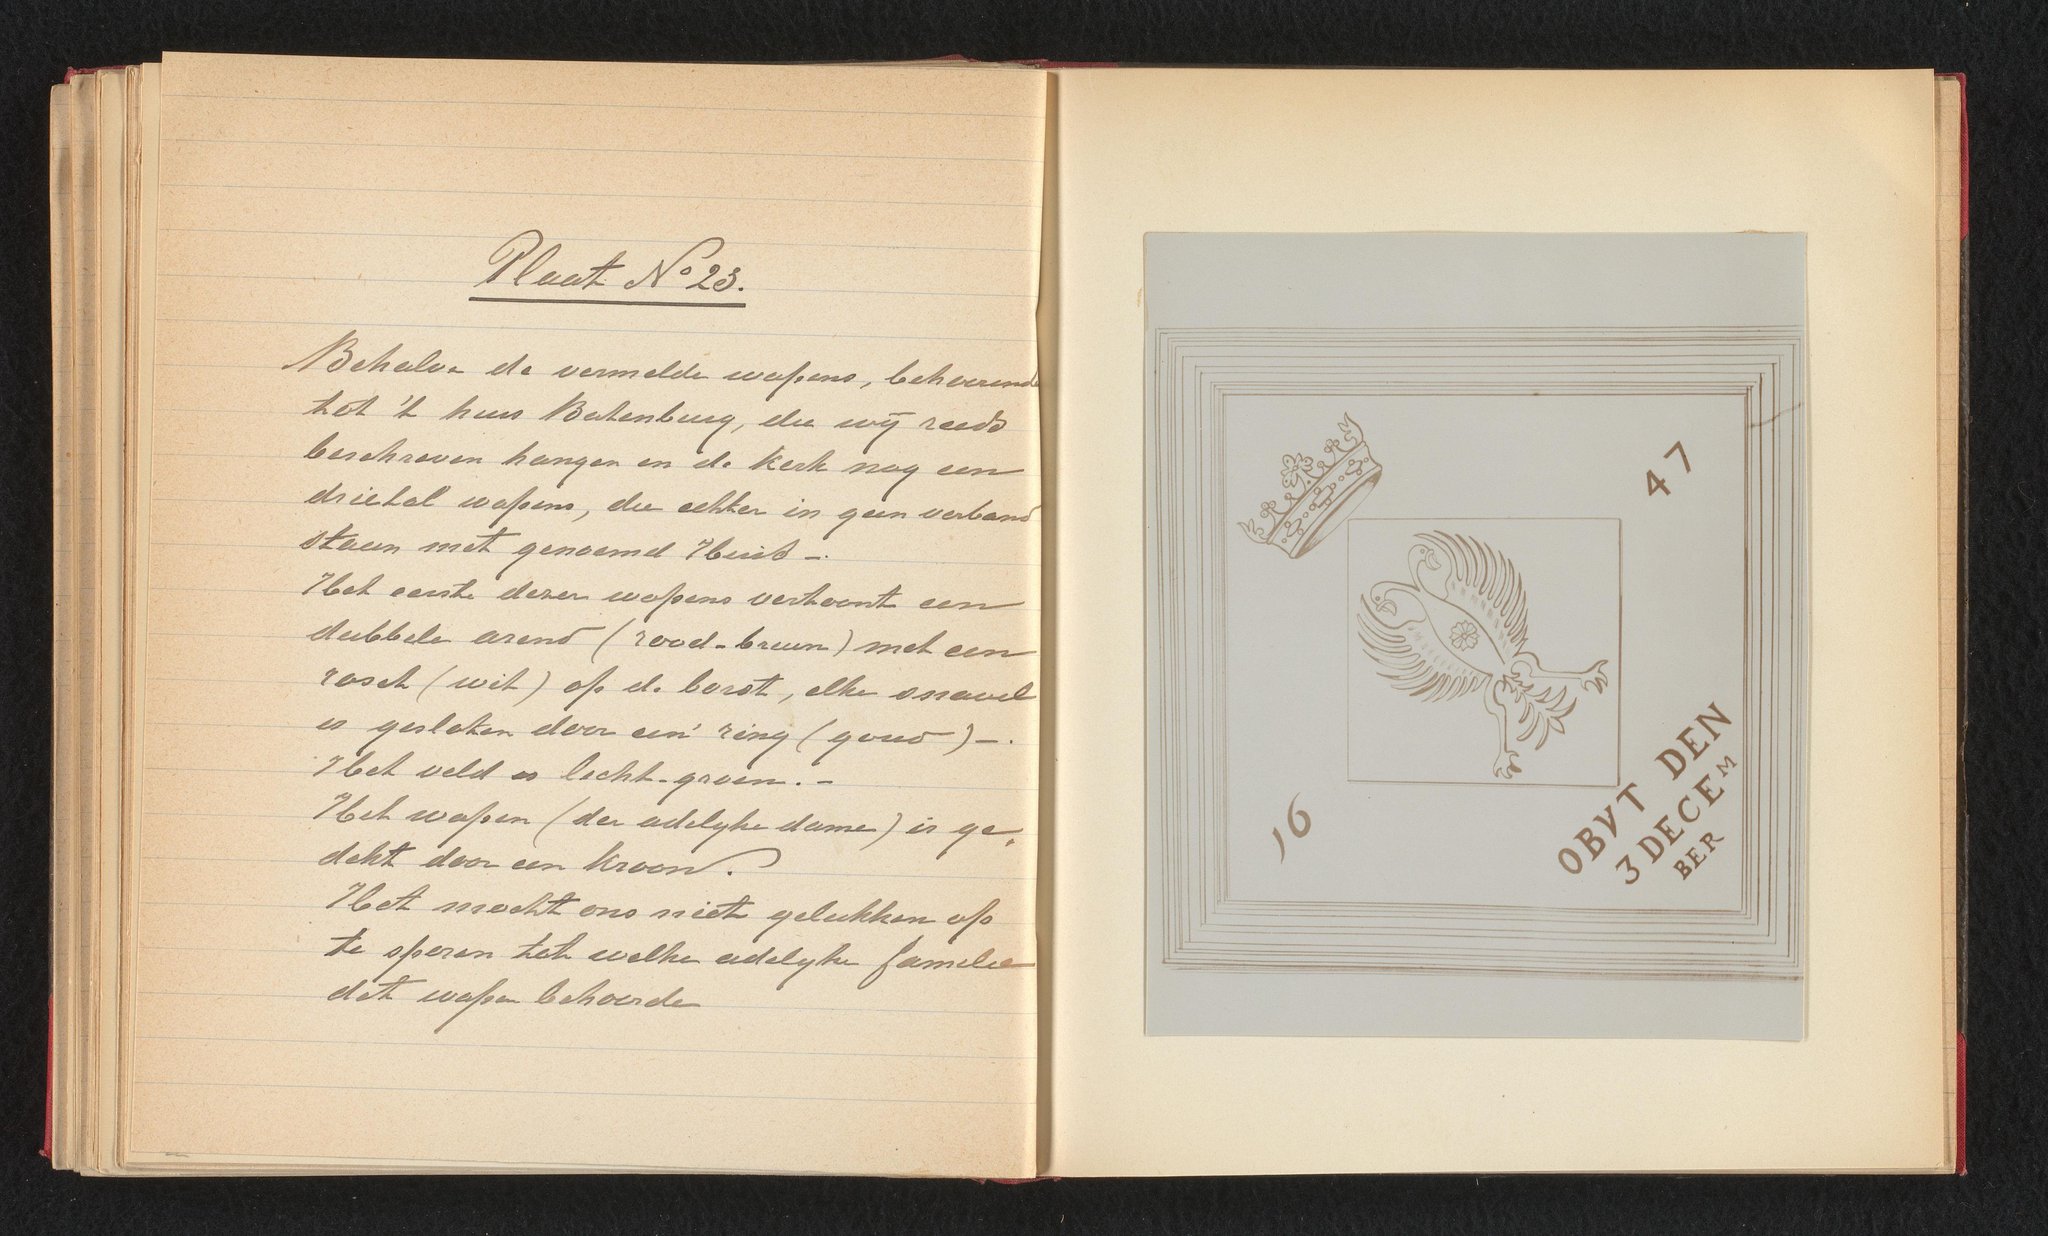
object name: page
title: Fotoreproductie van een getekend wapenbord in de Oude Sint-Victorkerk in Batenburg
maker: benjamin charlé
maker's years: 1845-1925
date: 1902-1907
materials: paper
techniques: collodion silver print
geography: batenburg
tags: armorial bearing, heraldry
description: Foto op negentigste ongenummerde pagina.